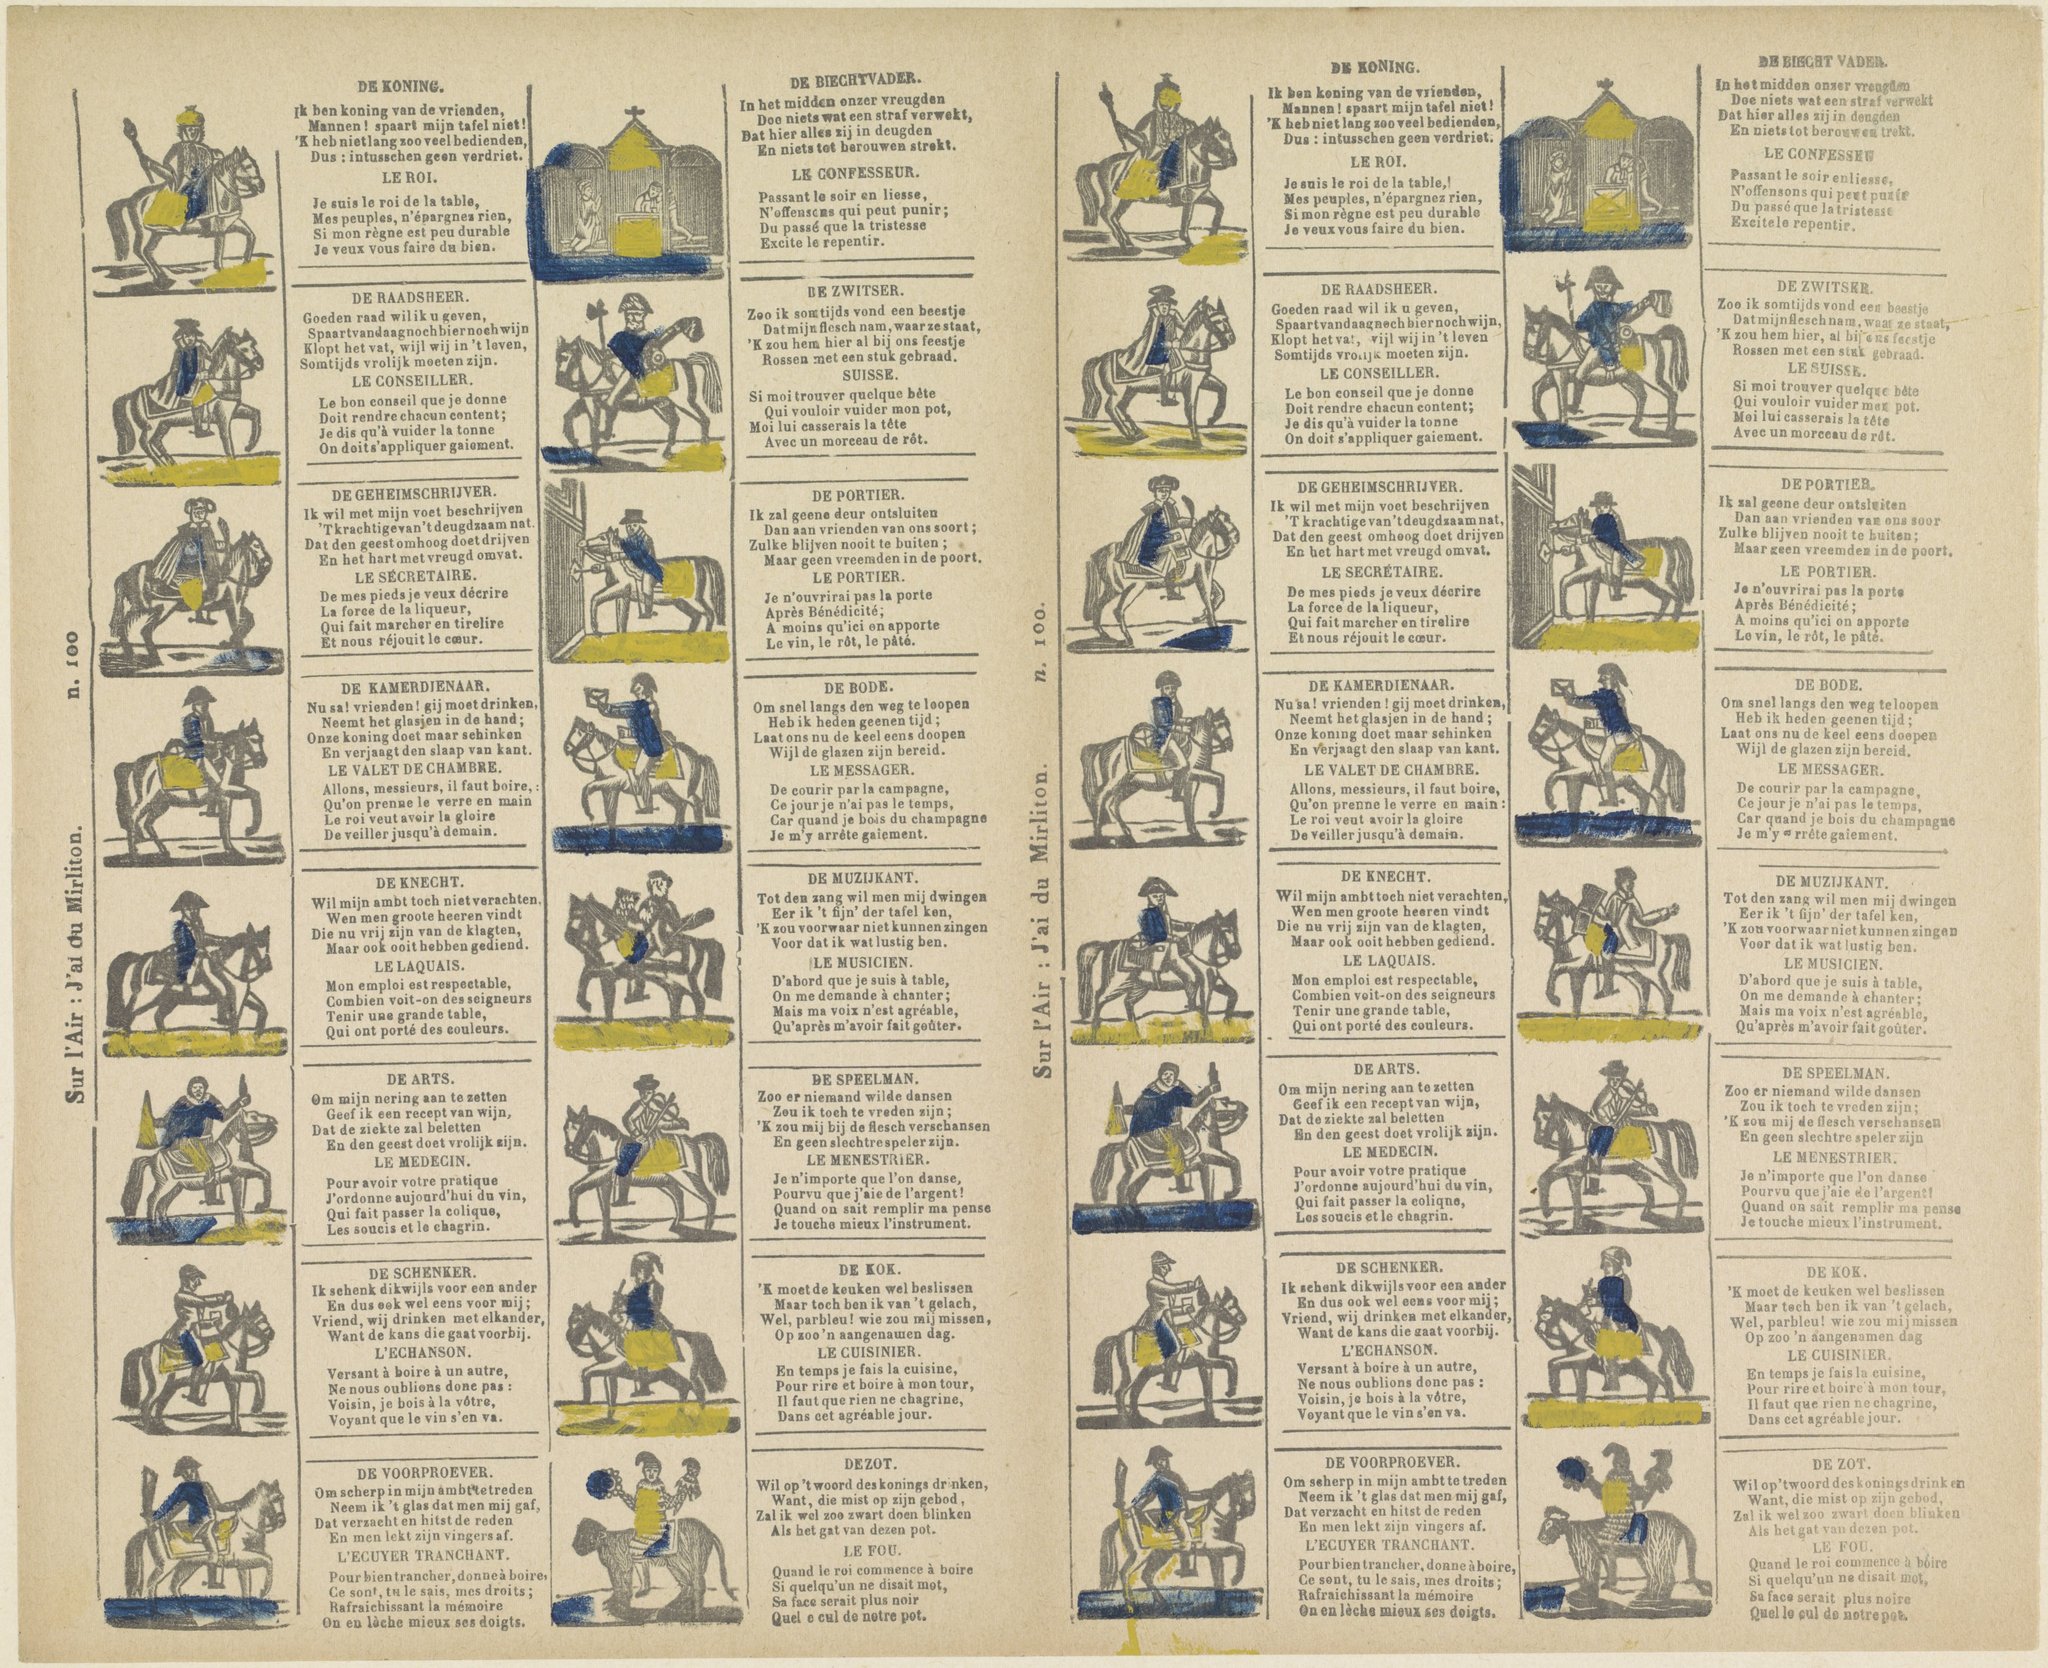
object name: print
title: Driekoningenbriefjes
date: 1800-1833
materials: paper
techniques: colour, letterpress printing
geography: turnhout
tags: twelfth night, usually falling on the eve of january 6, royal household; courtiers, retinue, train, epiphany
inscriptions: collector's mark: Lugt 2760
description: Blad met 32 voorstellingen (driekoningenbriefjes) van verschillende functies binnen het hof, waaronder een raadsman, een proever en een portier. Rechts naast elke afbeelding een vierregelig vers in het Nederlands en in het Frans. Genummerd midden links: n. 100.